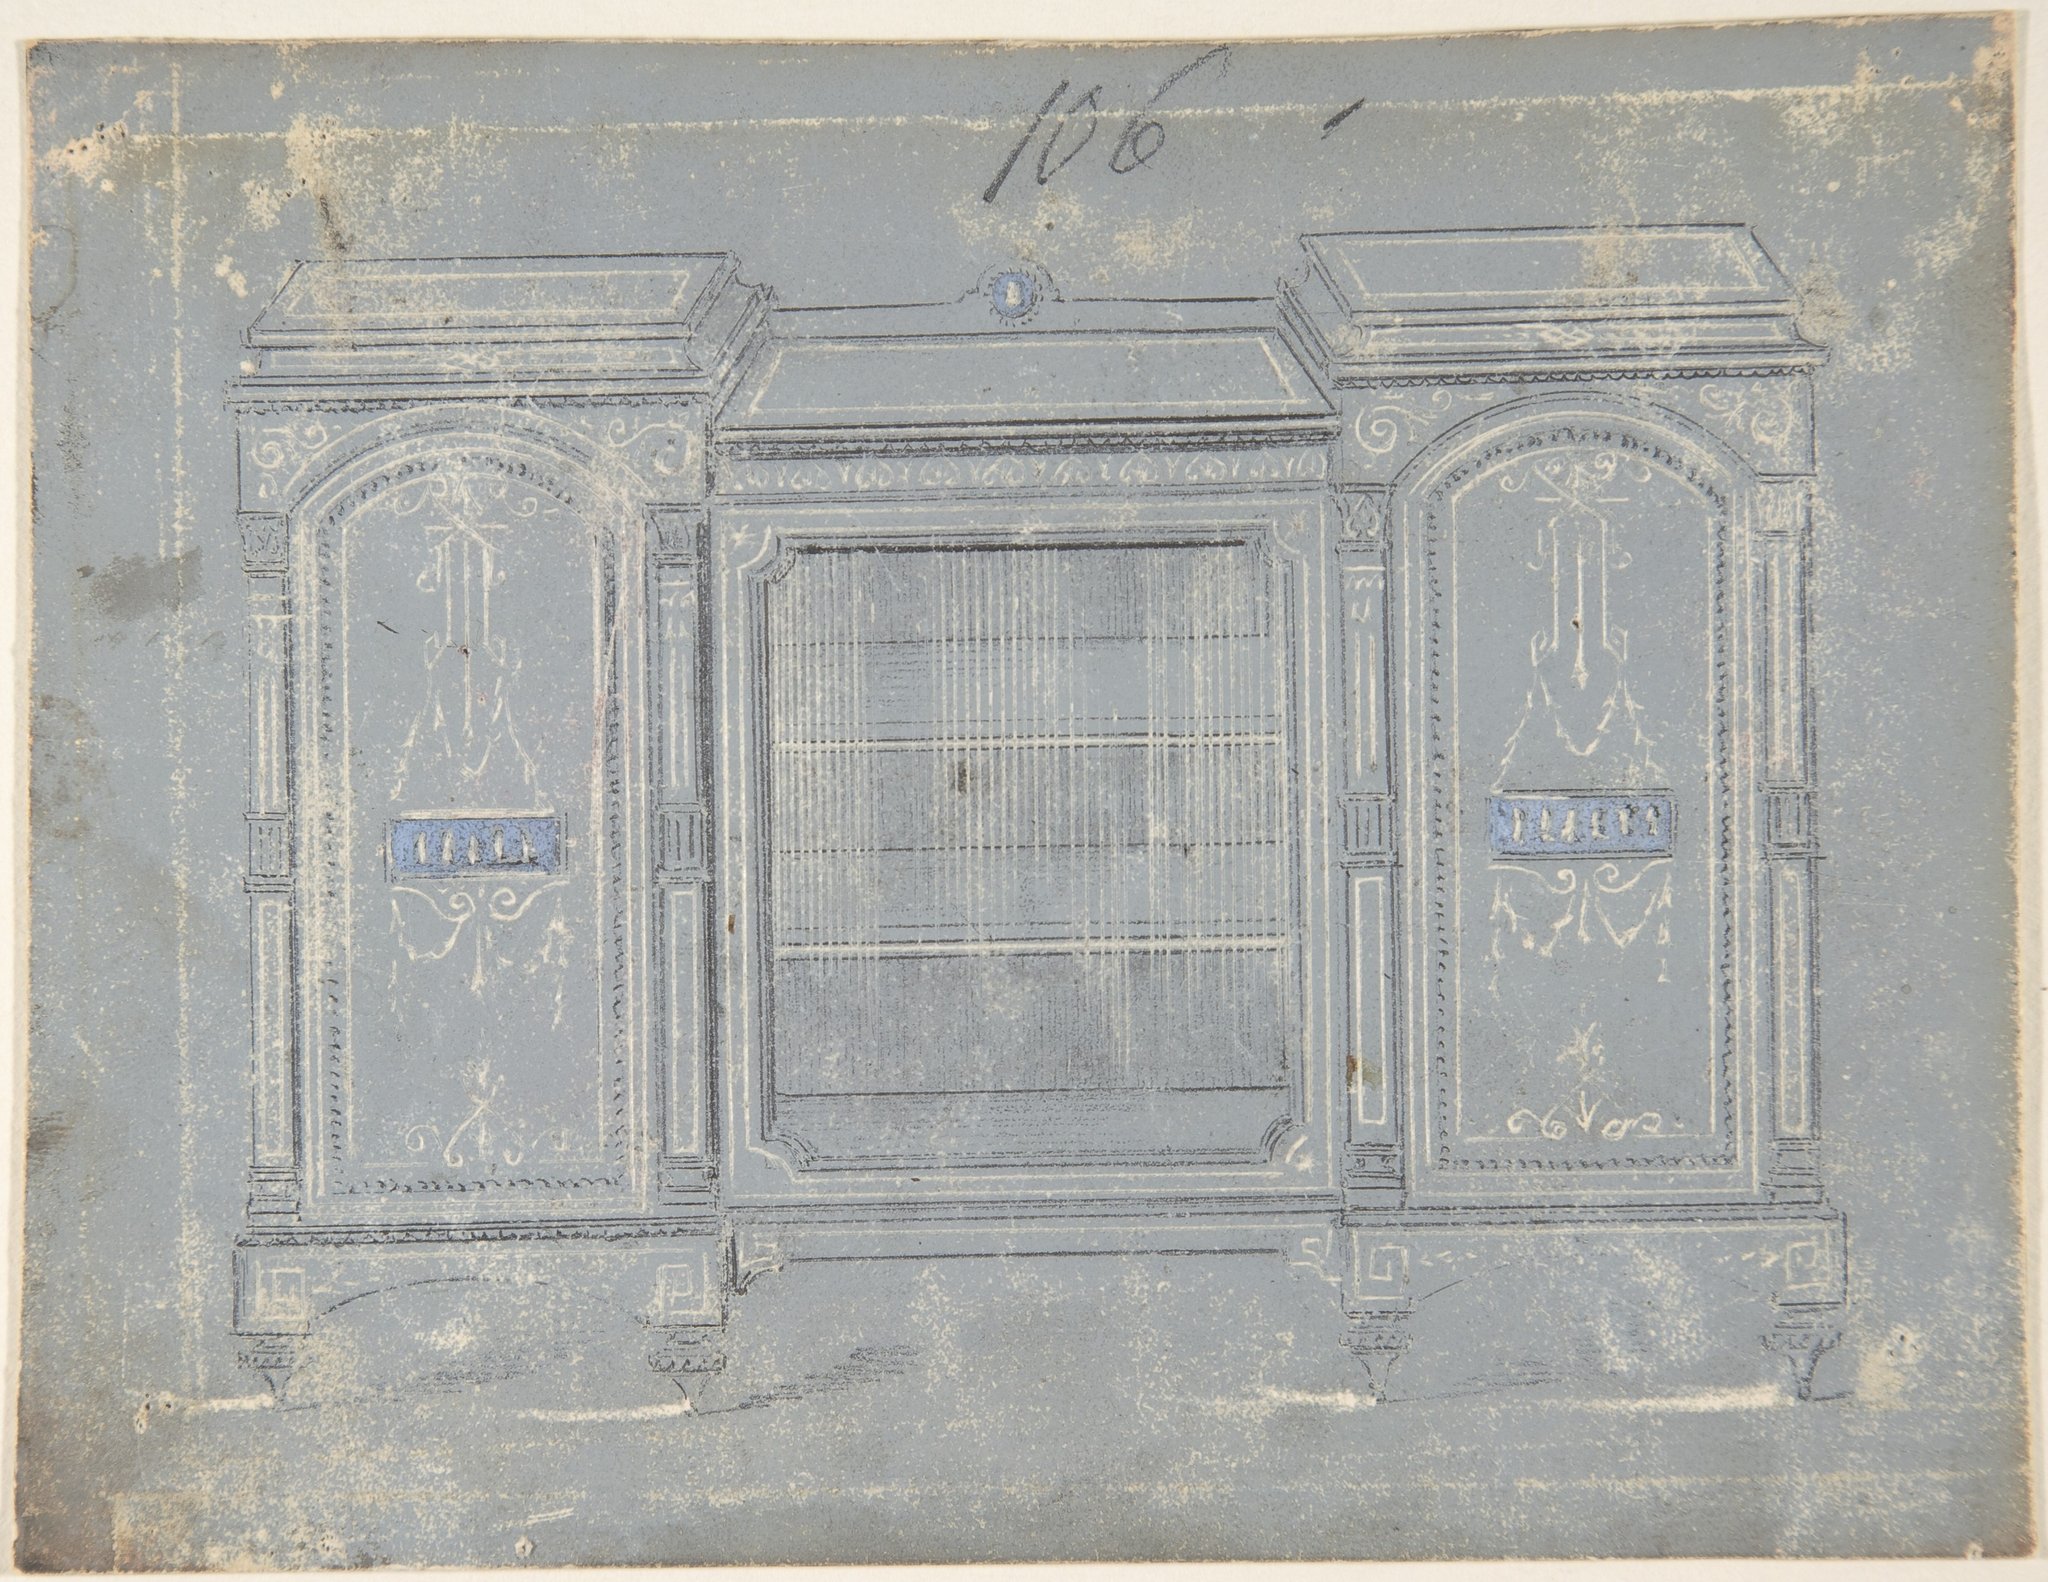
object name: drawing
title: Cabinet Design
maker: anonymous, british, 19th century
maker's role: artist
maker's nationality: british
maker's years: 1800-1900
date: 1801-1900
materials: ink, watercolor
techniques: pen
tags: cabinets